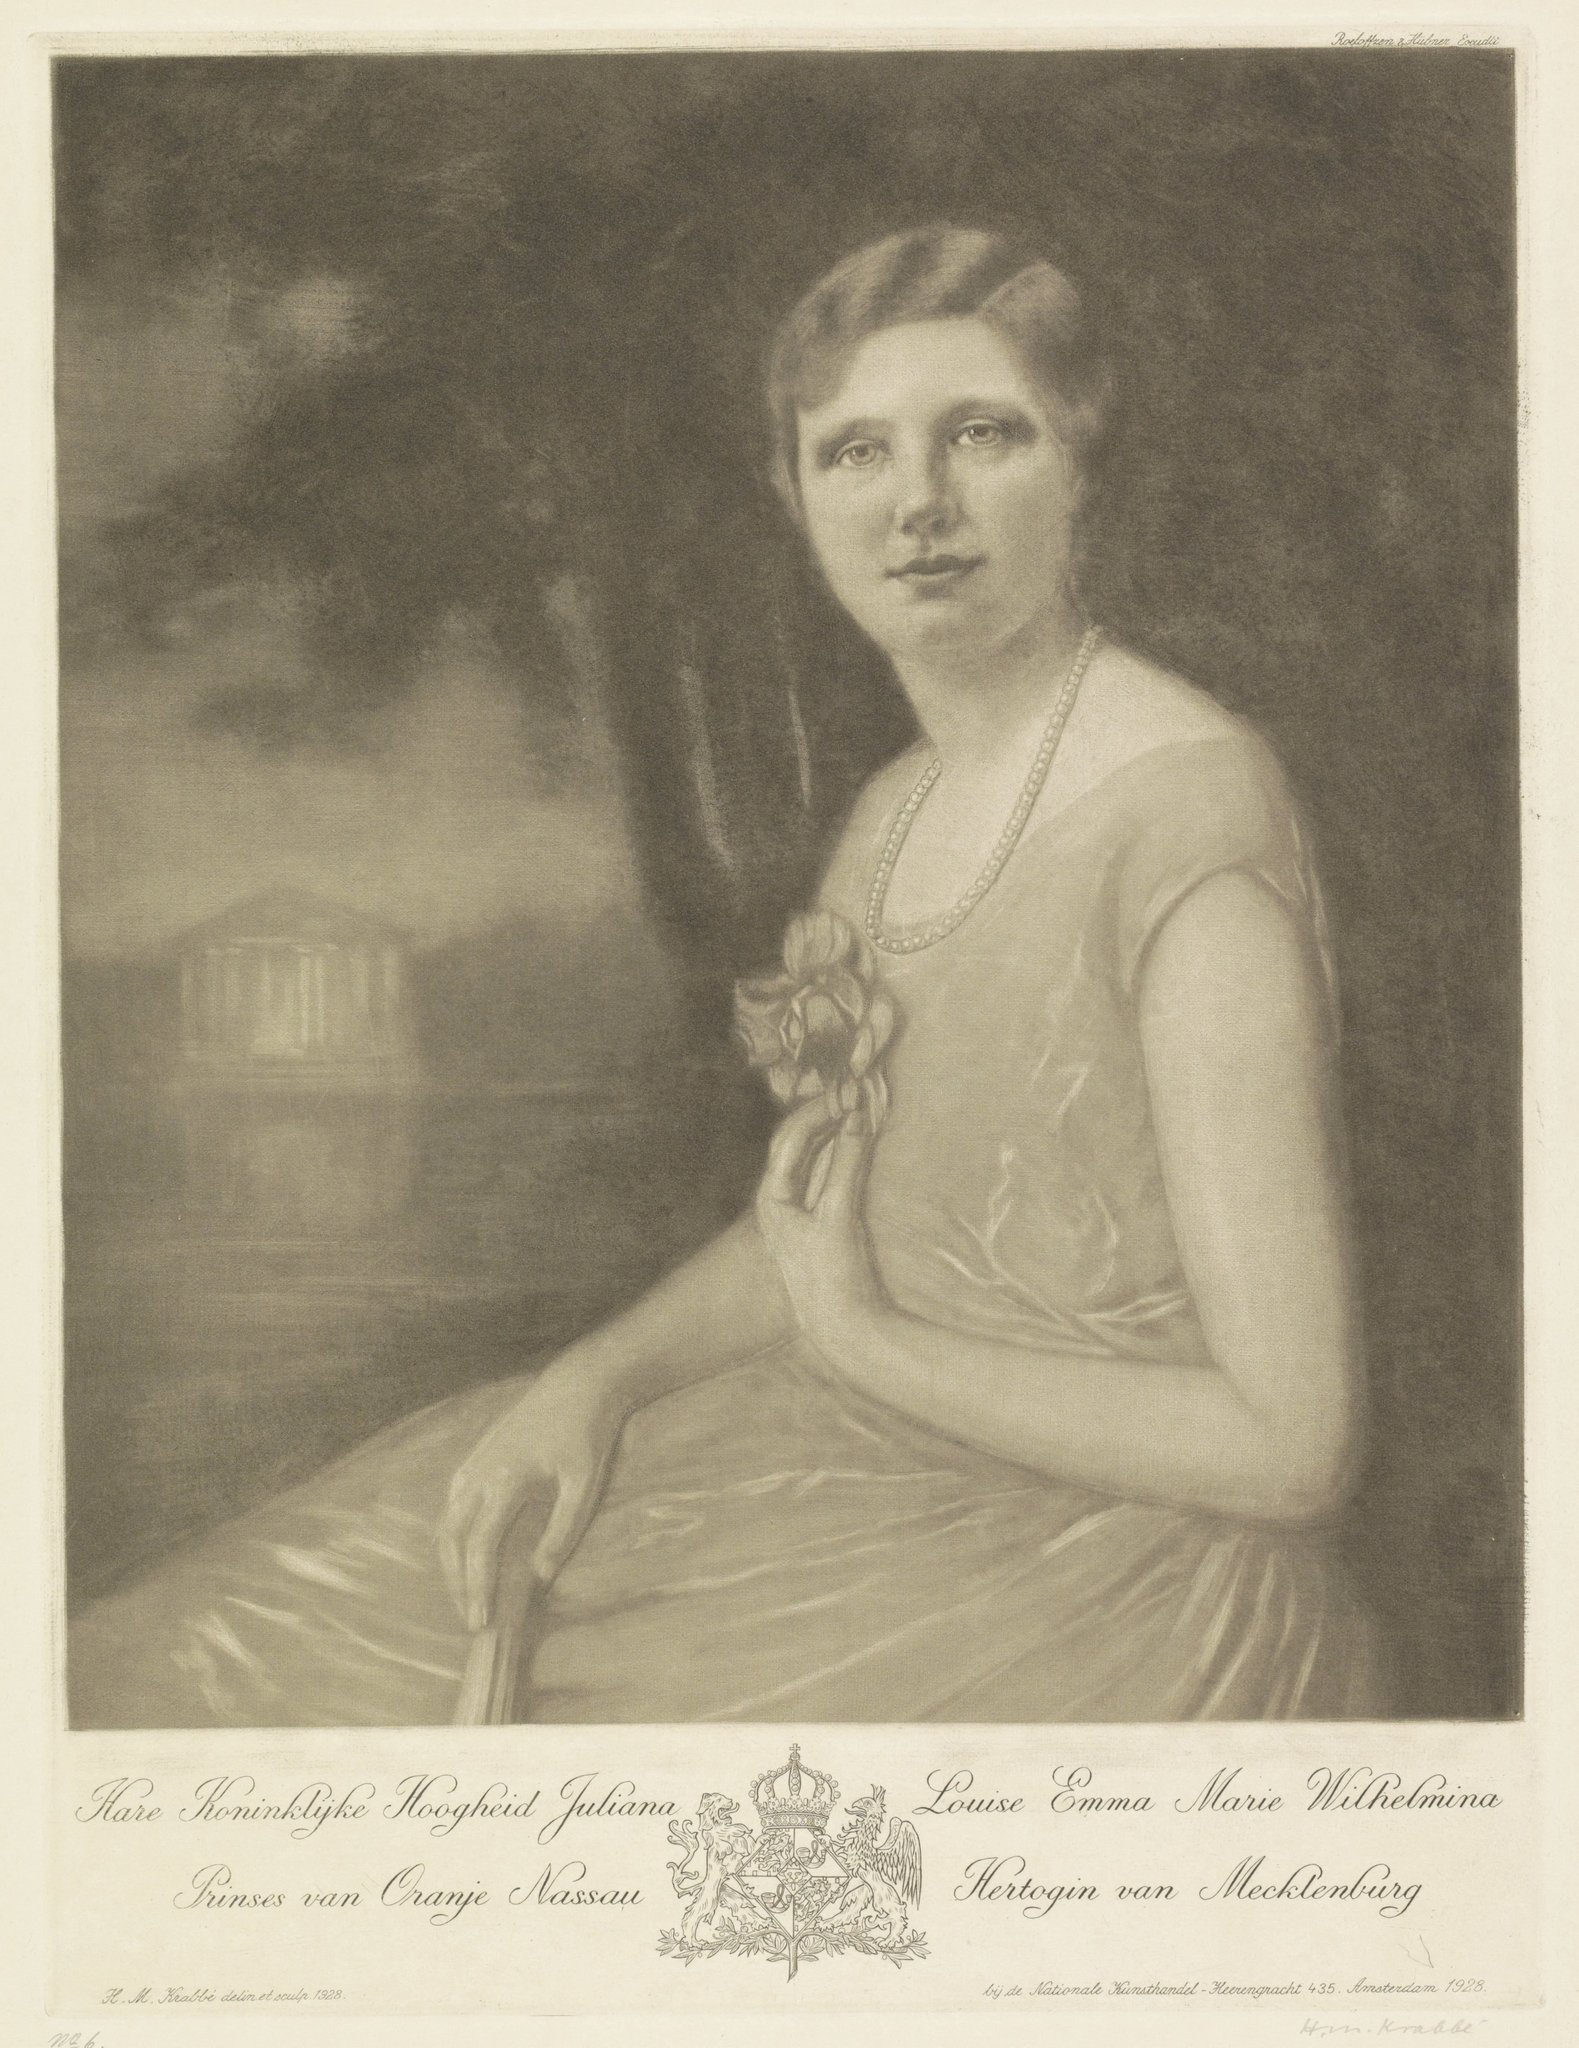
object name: print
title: Portret van Juliana, koningin der Nederlanden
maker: heinrich m. krabbé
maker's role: draughtsman, print maker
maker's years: 1868-1931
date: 1928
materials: paper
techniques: mezzotint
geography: amsterdam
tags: the hague, juliana of the netherlands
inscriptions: date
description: Portret van Juliana. In haar rechterhand een waaier. In haar linkerhand een bloem. Op de achtergrond een tempel. Midden onder een wapen. In de ondermarge haar naam en titels.